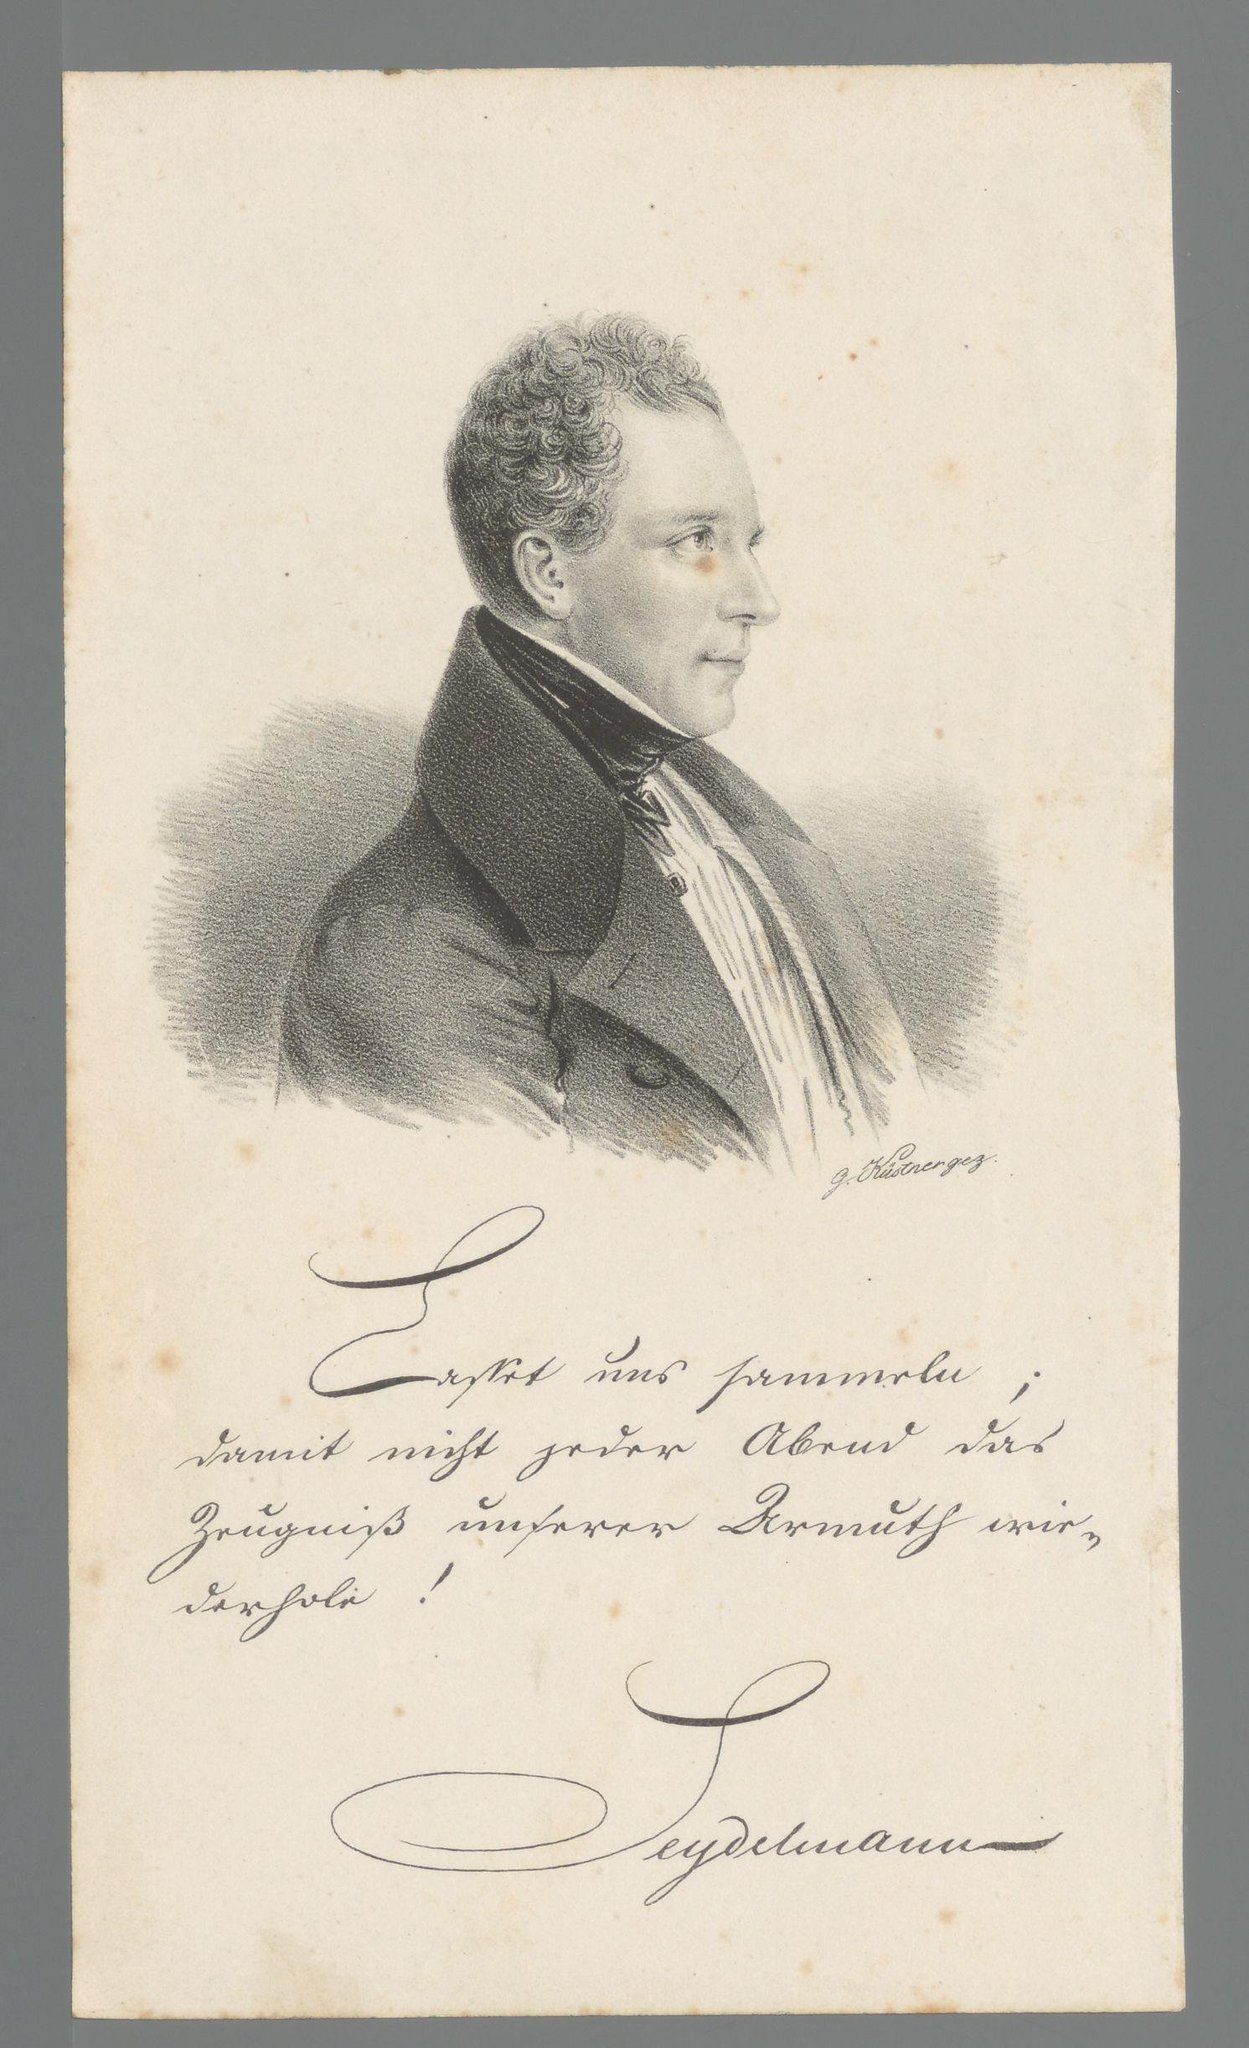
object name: print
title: Portret van Karl Seydelmann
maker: gottfried küstner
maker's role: print maker, printer, publisher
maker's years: 1800-1864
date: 1810-1864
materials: paper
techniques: lithograph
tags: berlin, historical persons, portrait of actor, actress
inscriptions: collector's mark: Lugt 2228